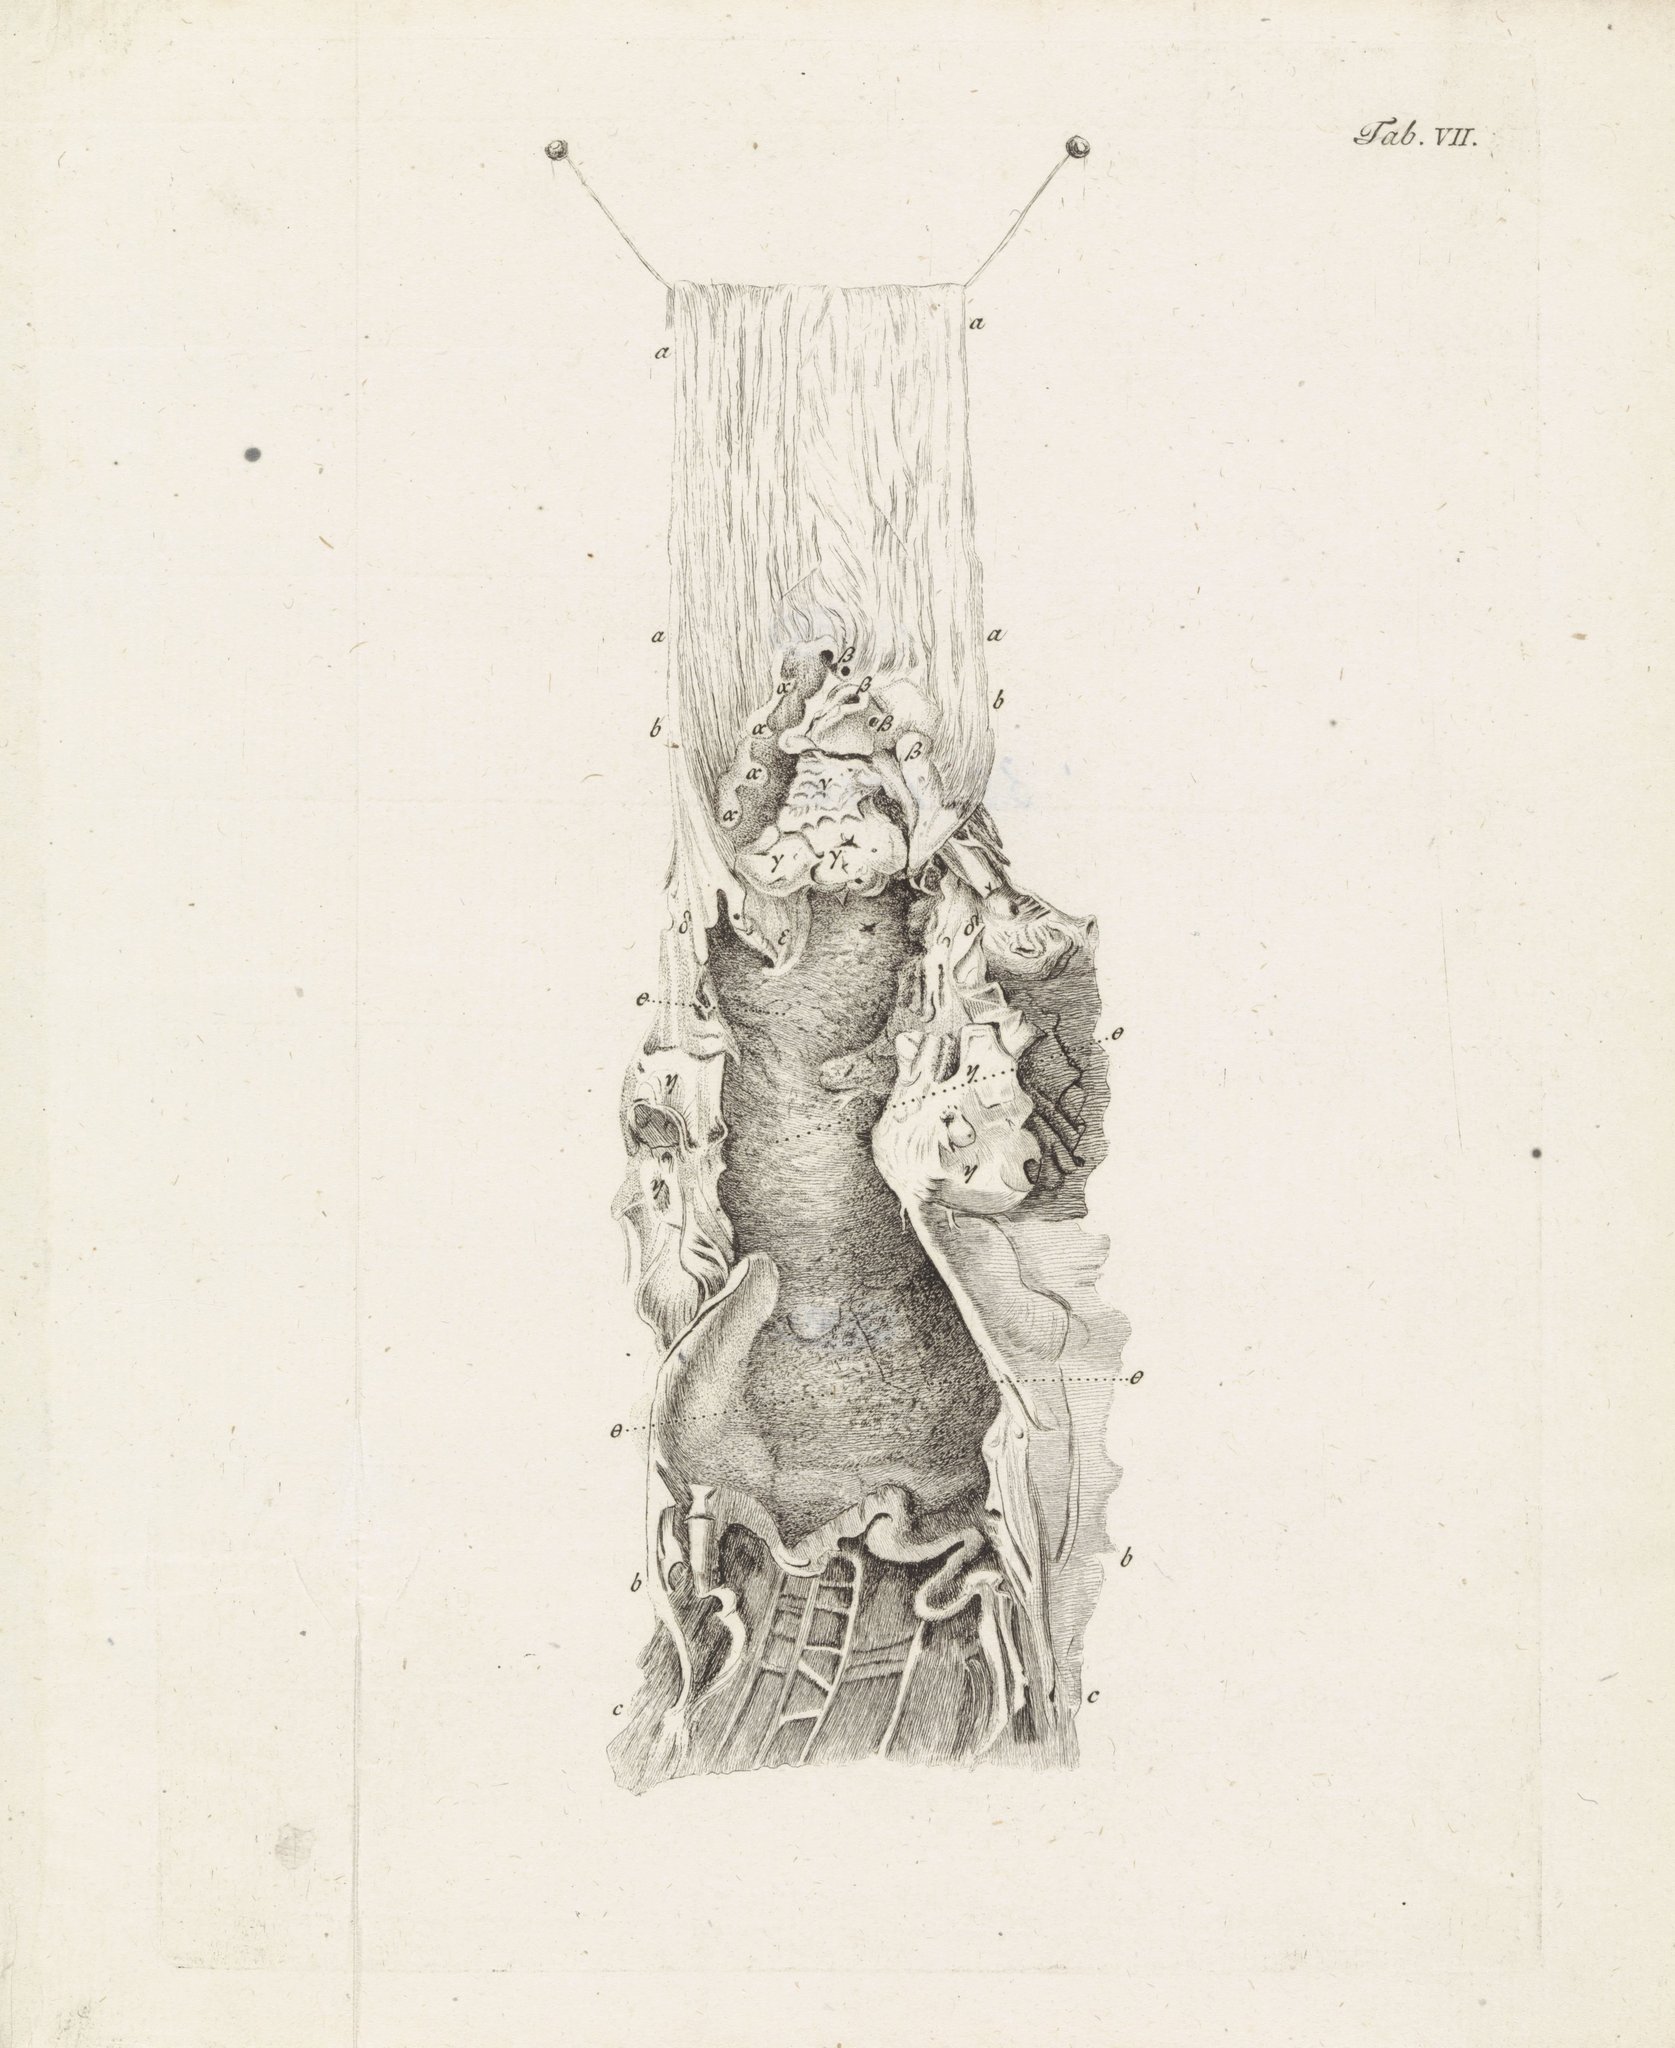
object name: print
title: Anatomische afbeelding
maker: robbert muys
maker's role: print maker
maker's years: 1742-1825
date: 1785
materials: paper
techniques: etching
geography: rotterdam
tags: physiology and anatomy (+ scientific research)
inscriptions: collector's mark: Lugt 2760, collector's mark: Lugt 2228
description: Prent uit: Bleuland, Janus. Observationes anatomico-medicæ de sana et morbosa oesophagi structura. Leiden: Abraham en Jan Honkoop, 1785.